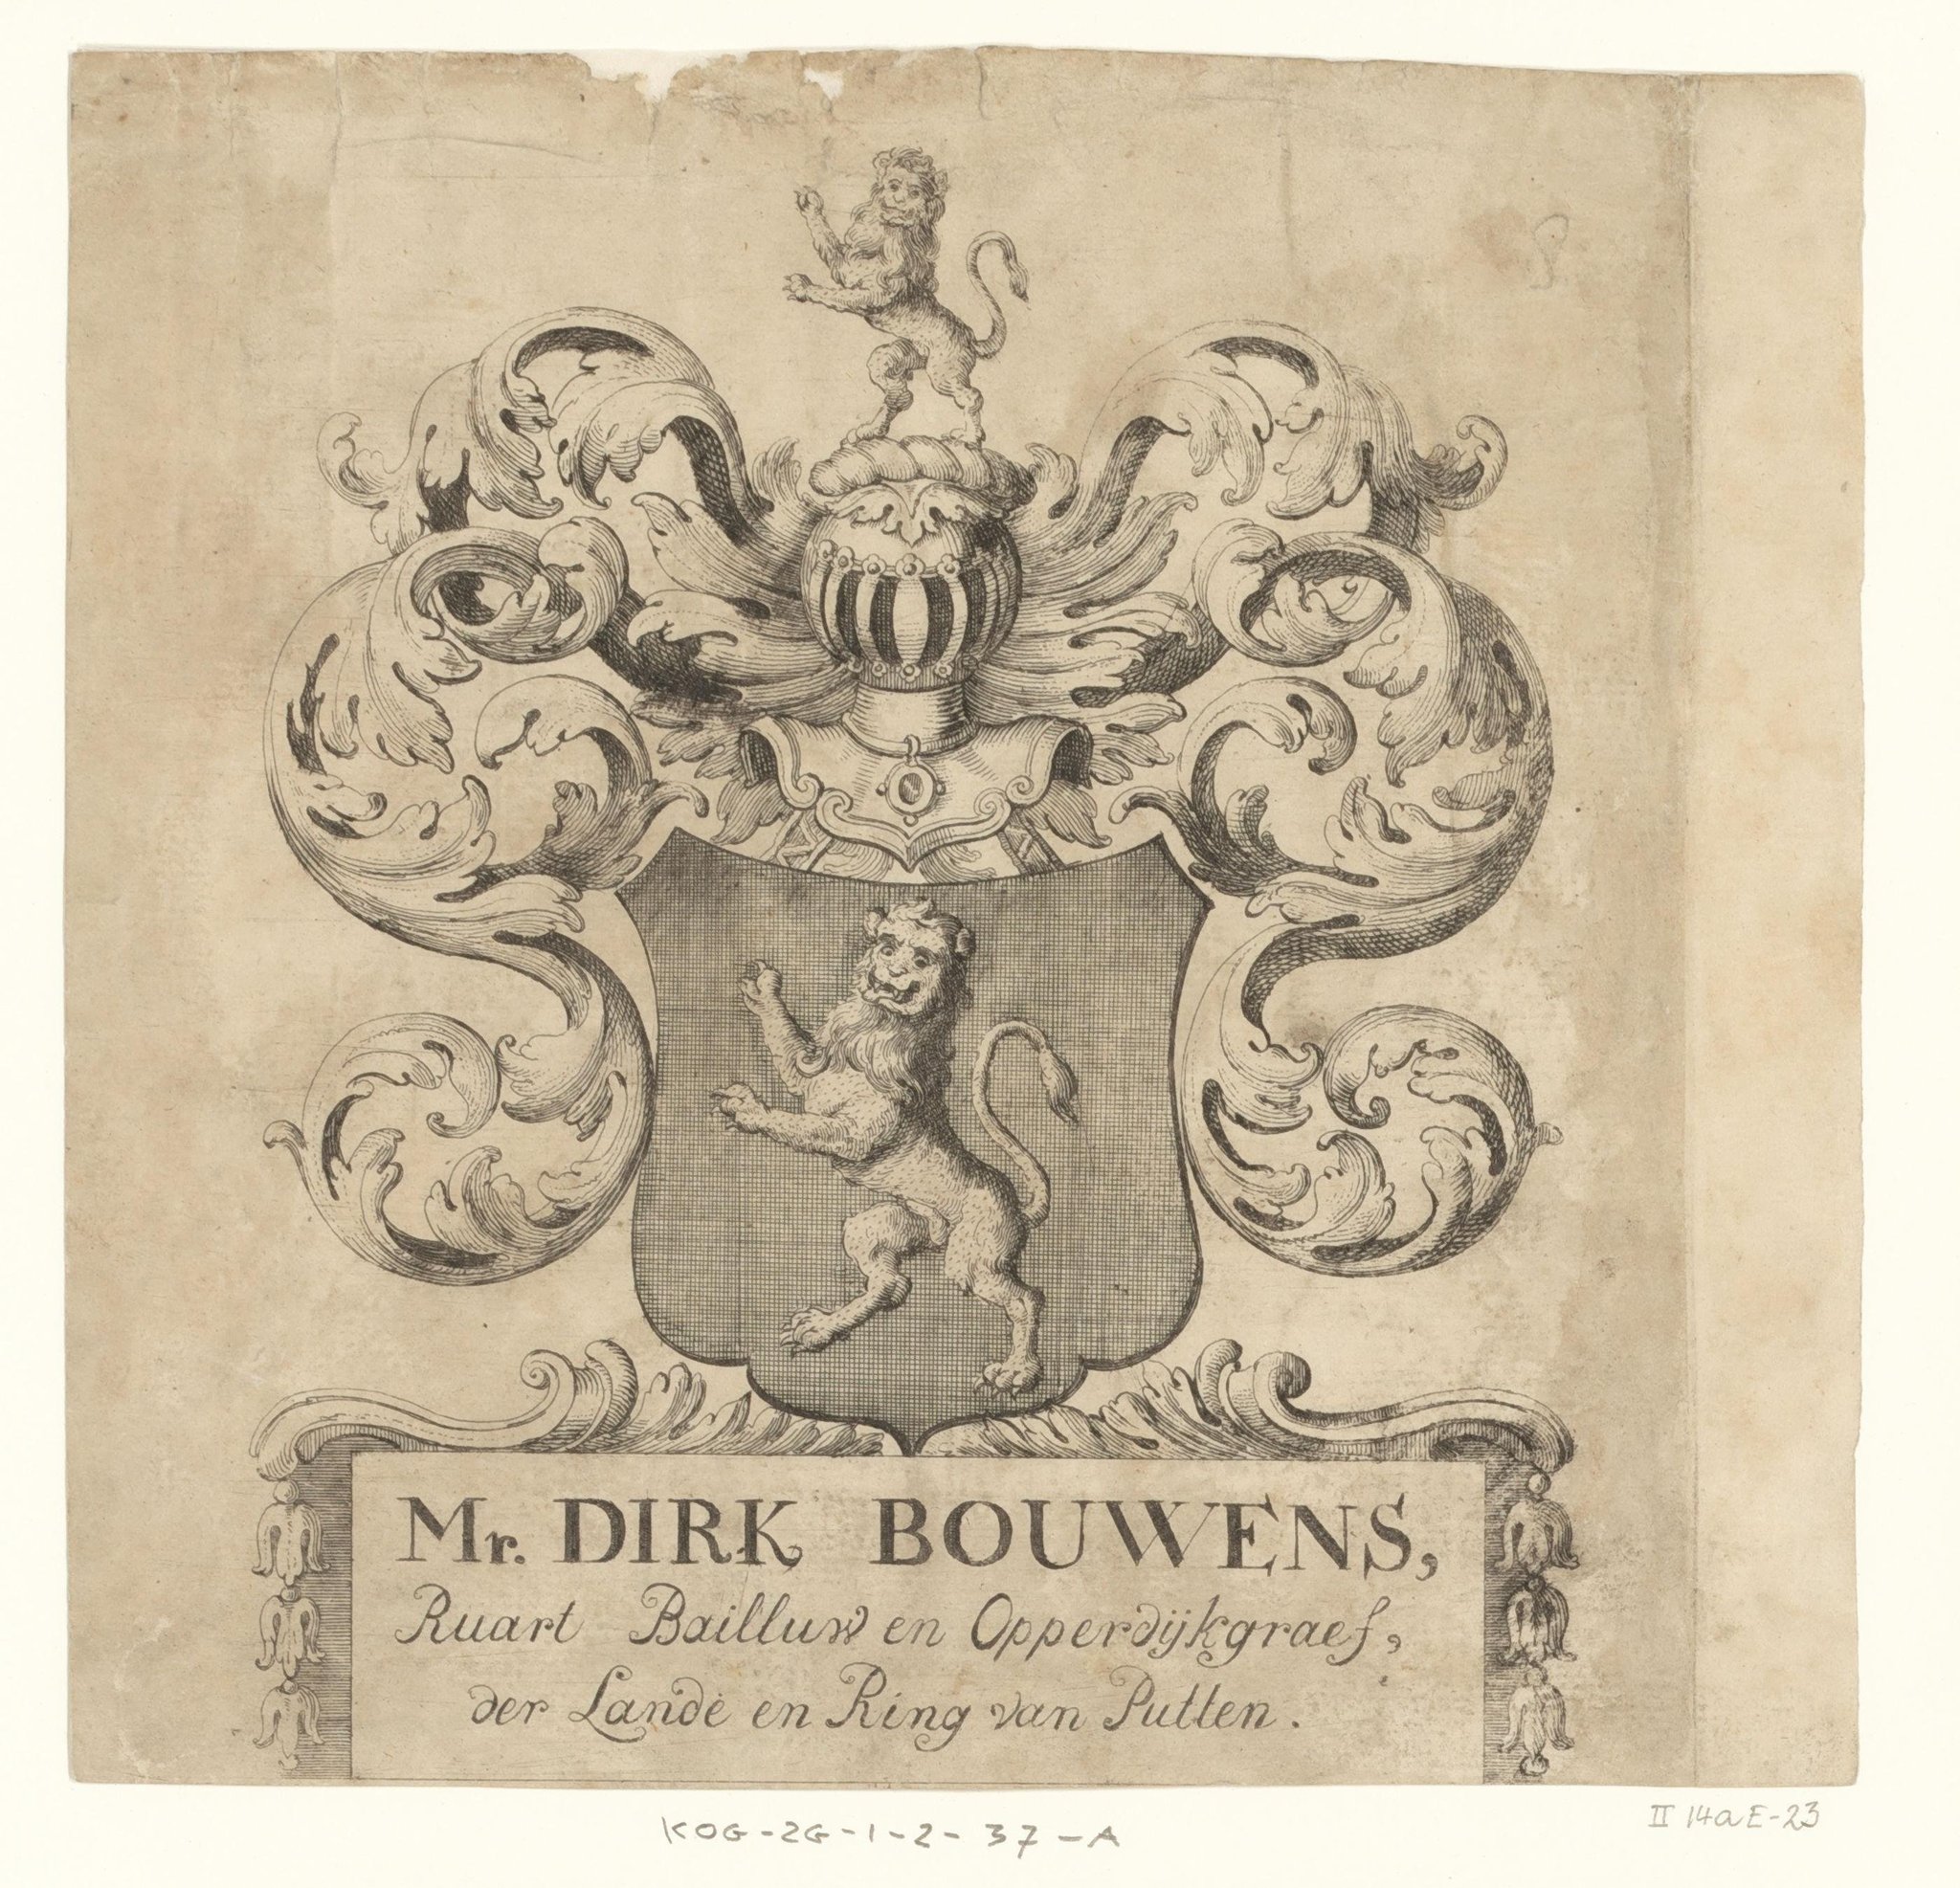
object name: print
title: Familiewapen van Mr. Dirk Bouwens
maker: Anonymous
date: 1689-1690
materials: paper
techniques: engraving, etching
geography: netherlands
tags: armorial bearing, heraldry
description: Familiewapen van Mr. Dirk Bouwens, opperdijkgraaf der Lande en Ring van Putten. Onderdeel van een groep van twaalf wapens van magistraten van Utrecht. Mogelijk behorend bij een grote kaart van bijvoorbeeld een hoogheemraadschap. Onderwerpsrubrieken binnen de Atlas Zeden en Gewoonten: Regeering, Wapens (Heraldiek), Geslachtswapens.